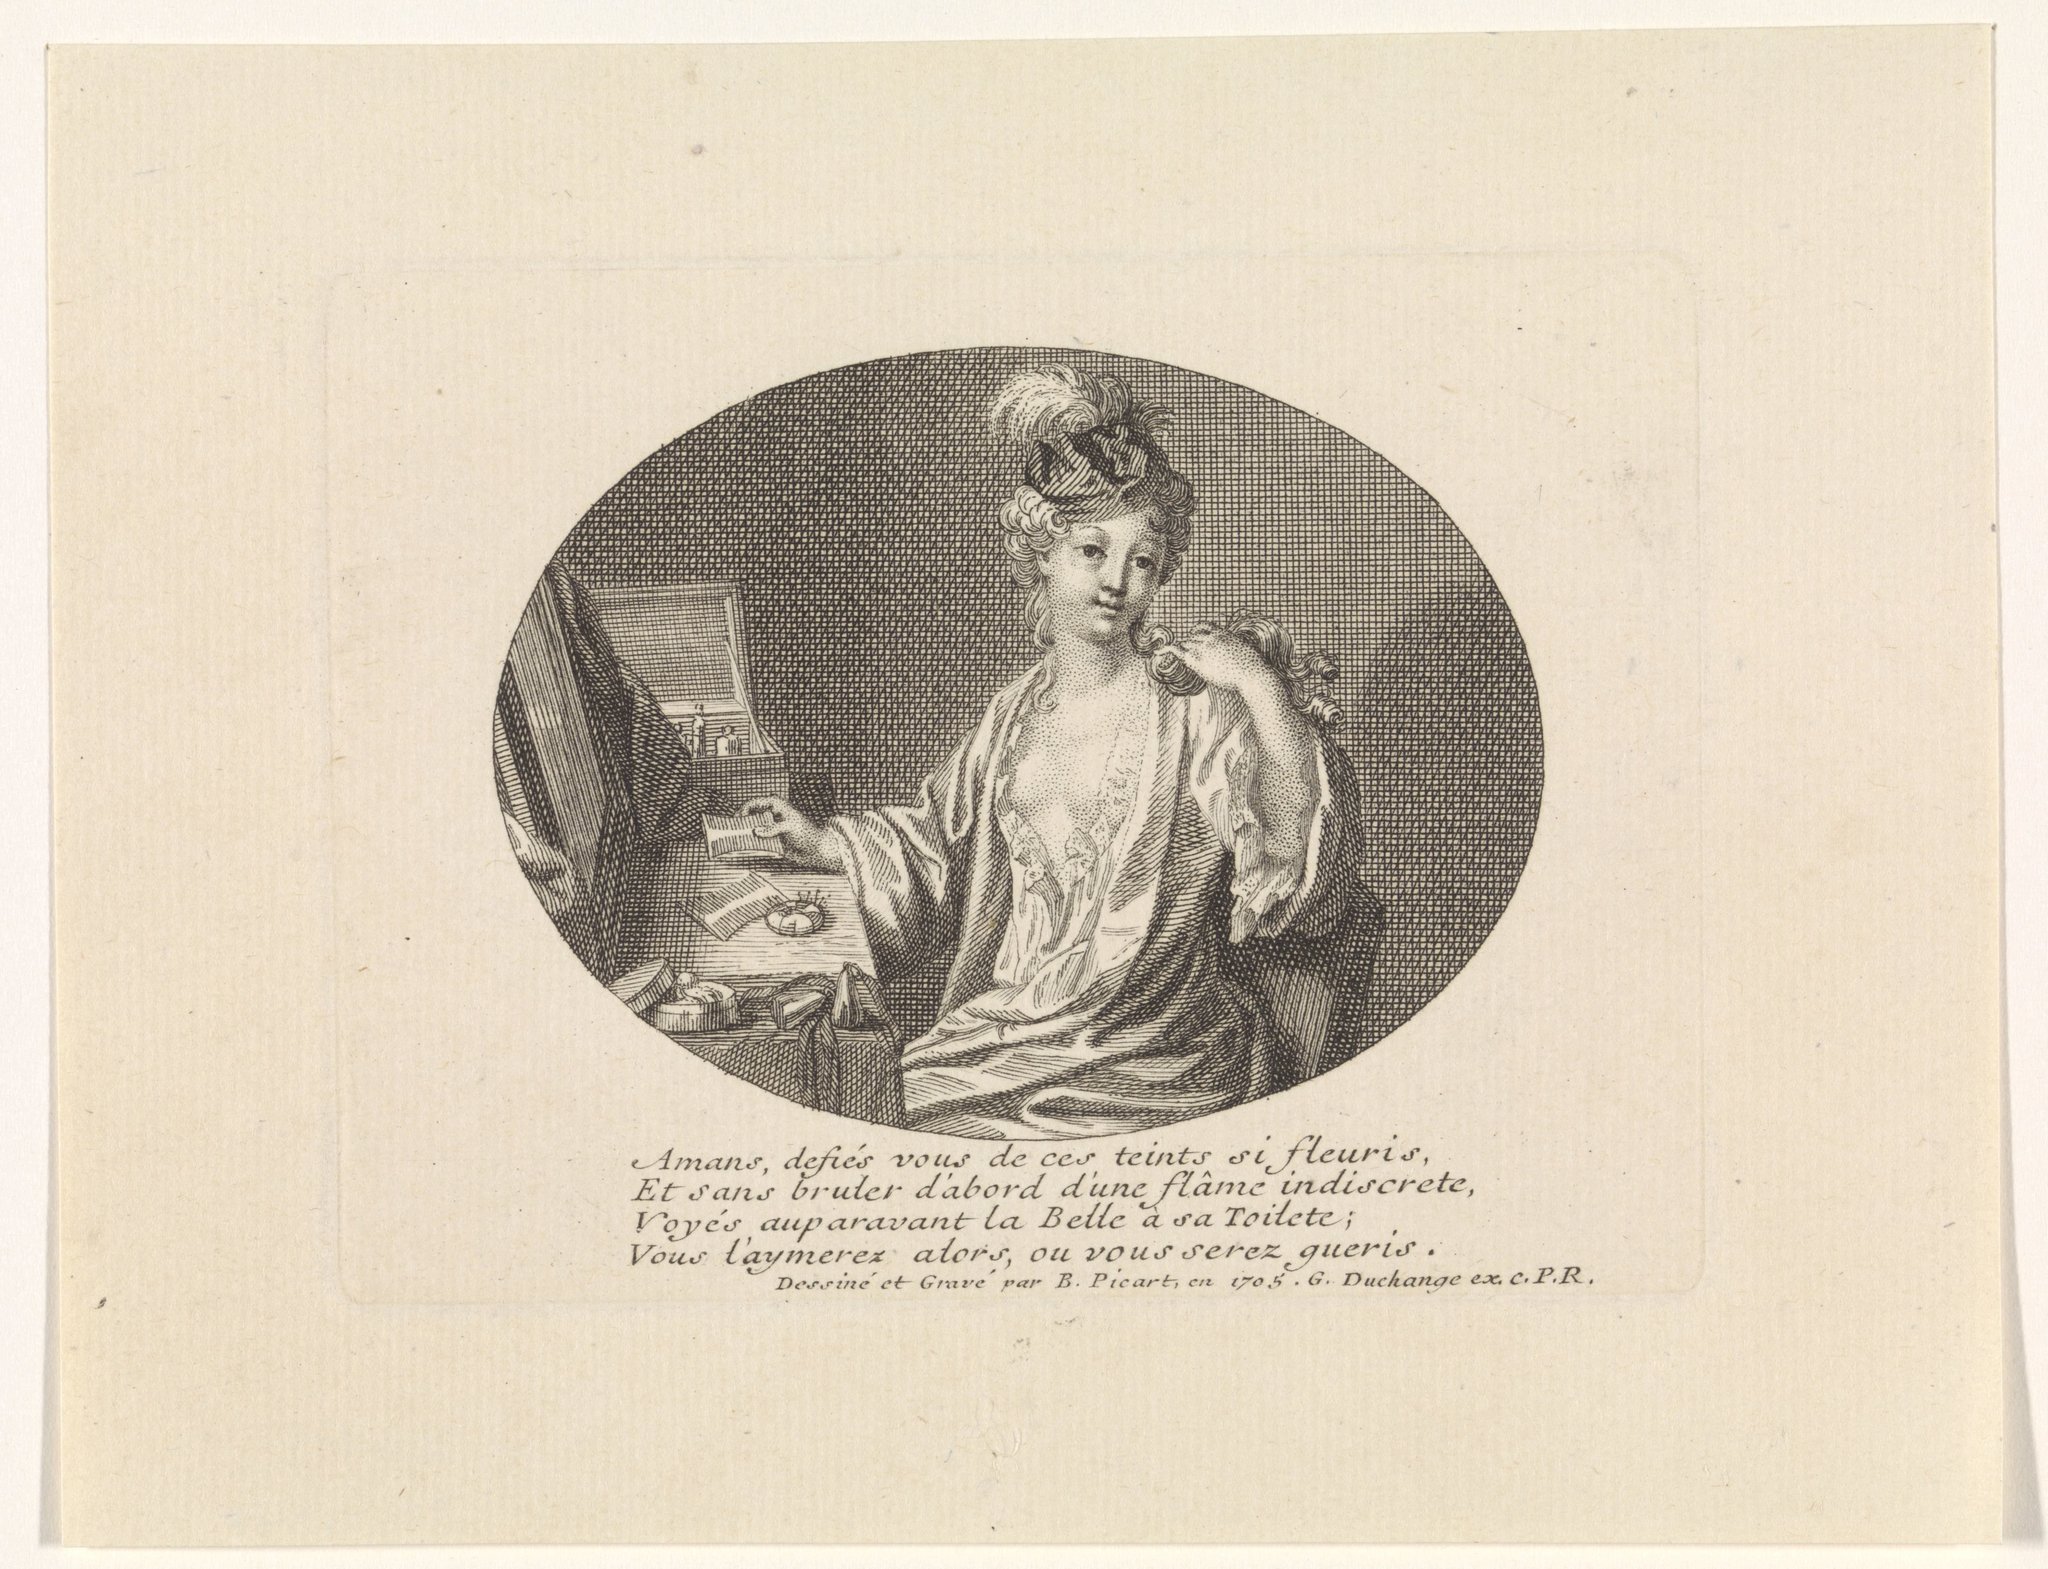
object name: print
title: Vrouw aan haar toilet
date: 1705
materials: paper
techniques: engraving, etching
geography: paris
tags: whore, prostitute, making toilet - aa - (for) women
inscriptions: collector's mark: Lugt 2228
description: Een vrouw zit aan haar toilettafel waarop een spiegel en poederdozen. In haar hand houdt ze een kam. Zij draagt een jurk die haar borsten vrijwel onbedekt laat. In de marge een vierregelig gedicht in het Frans.